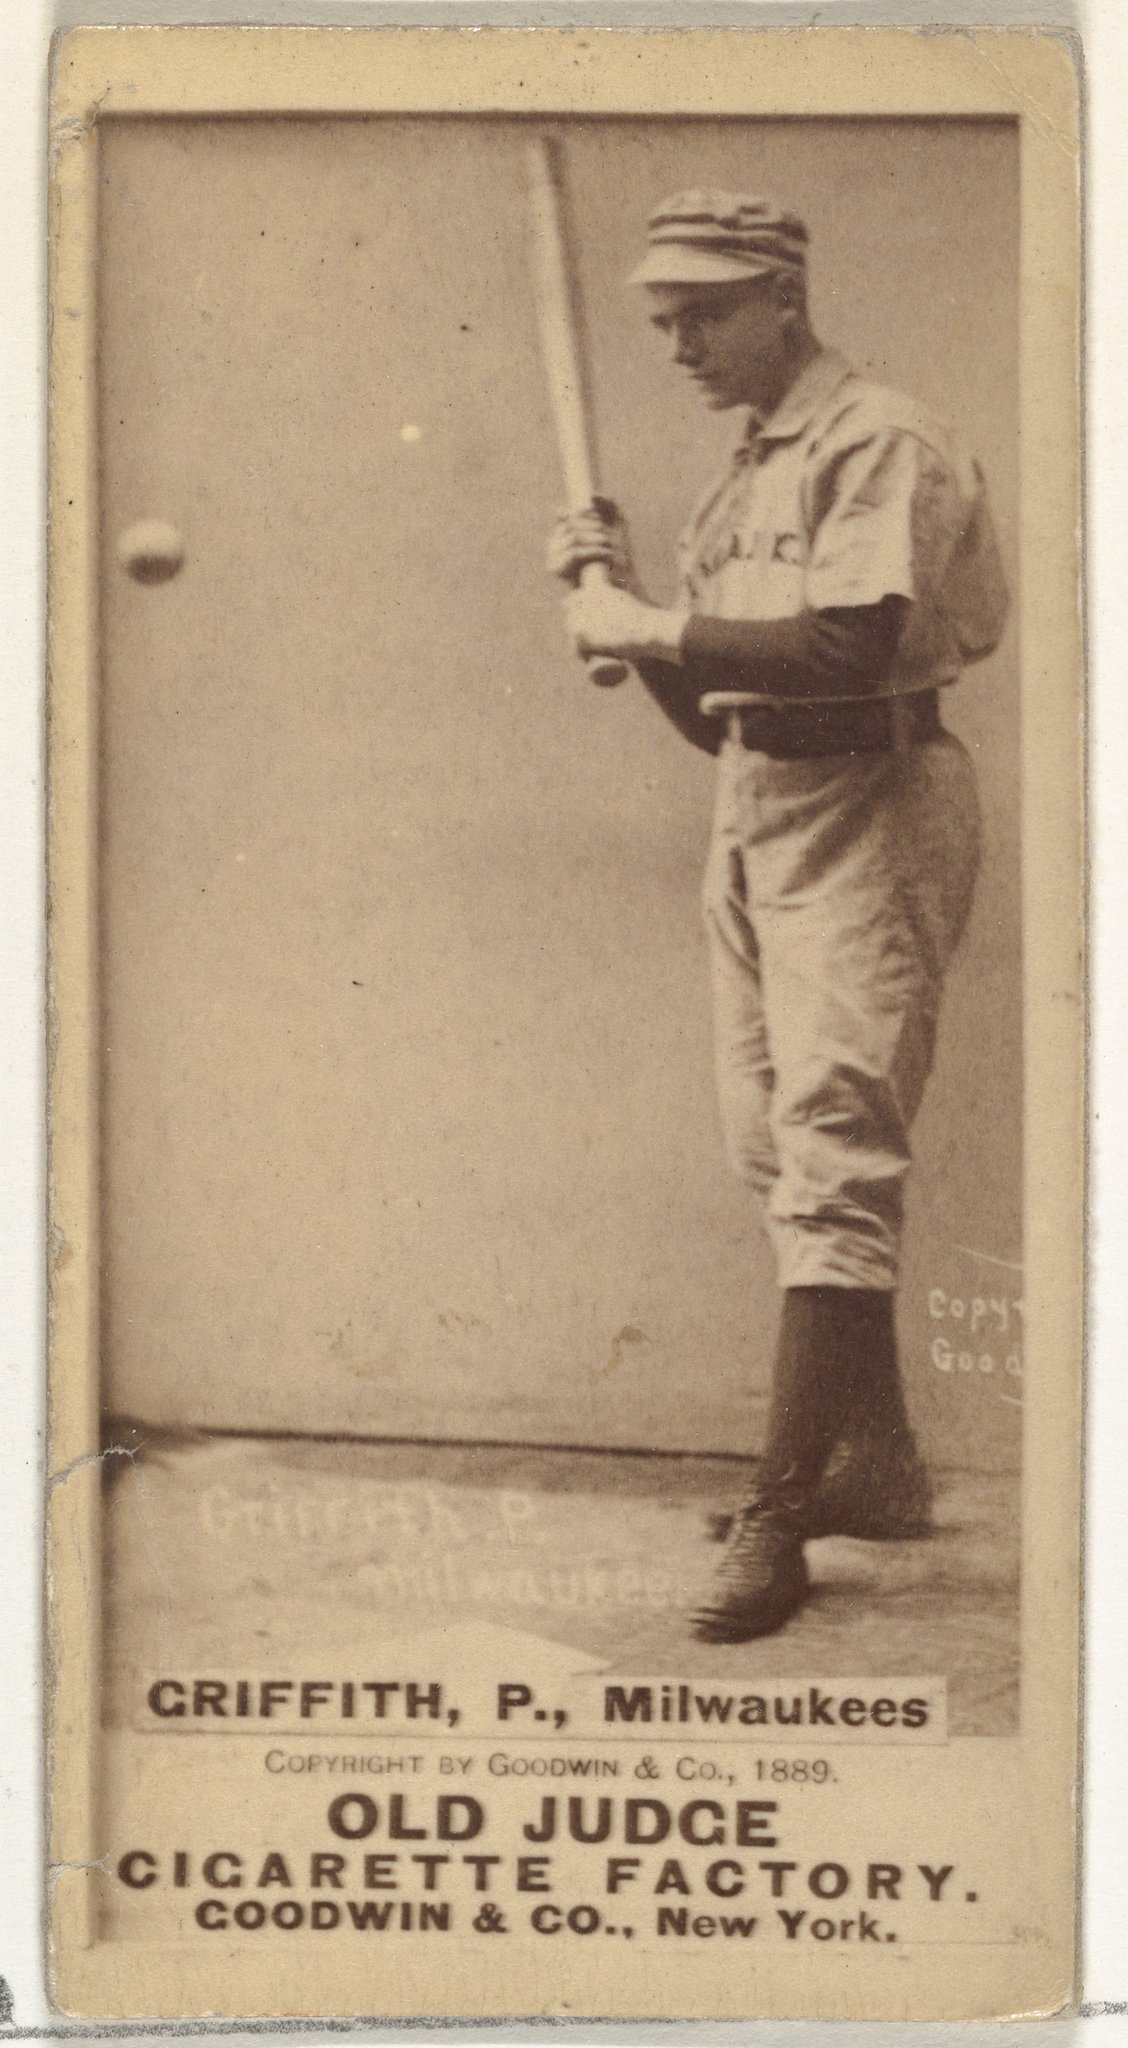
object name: baseball card, photograph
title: Clark Calvin "Old Fox" Griffith, Pitcher, Milwaukee, from the Old Judge series (N172) for Old Judge Cigarettes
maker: goodwin & company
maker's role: publisher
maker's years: 1850-1950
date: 1889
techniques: albumen silver print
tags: men,portraits,baseball,athletes